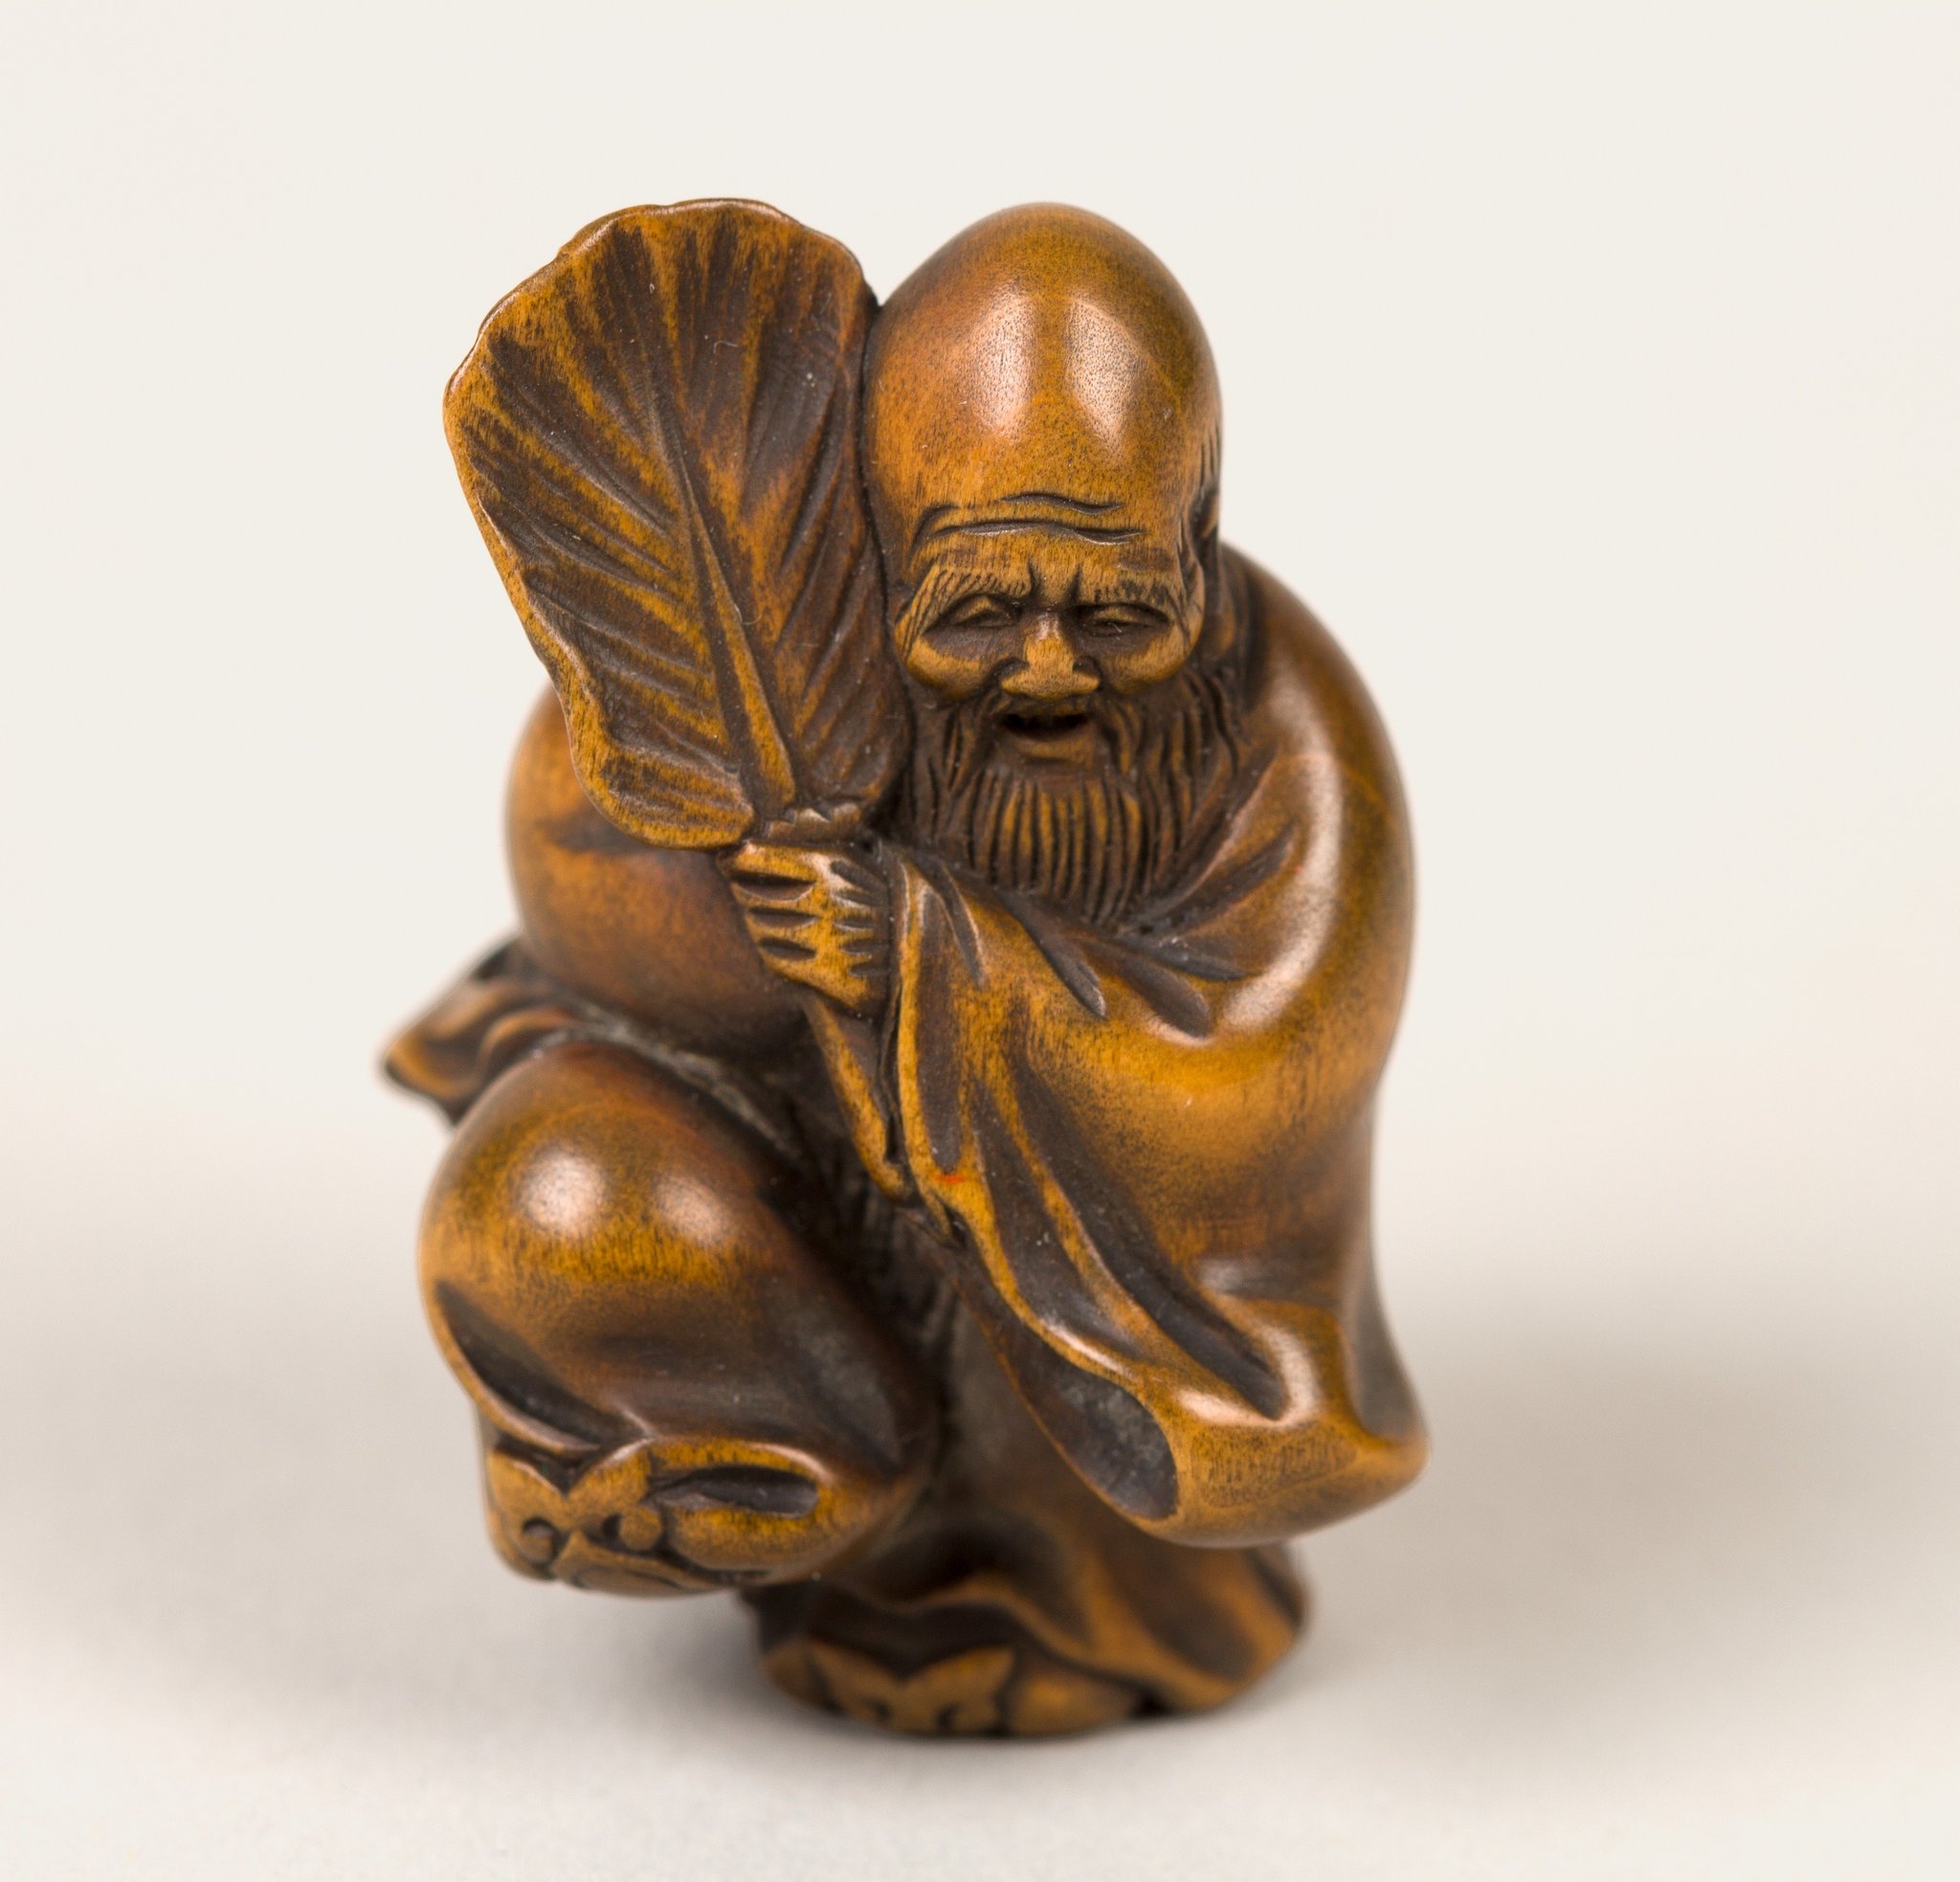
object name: netsuke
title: Netsuke of Old Man with a Fan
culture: japanese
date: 1801-1900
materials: wood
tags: men